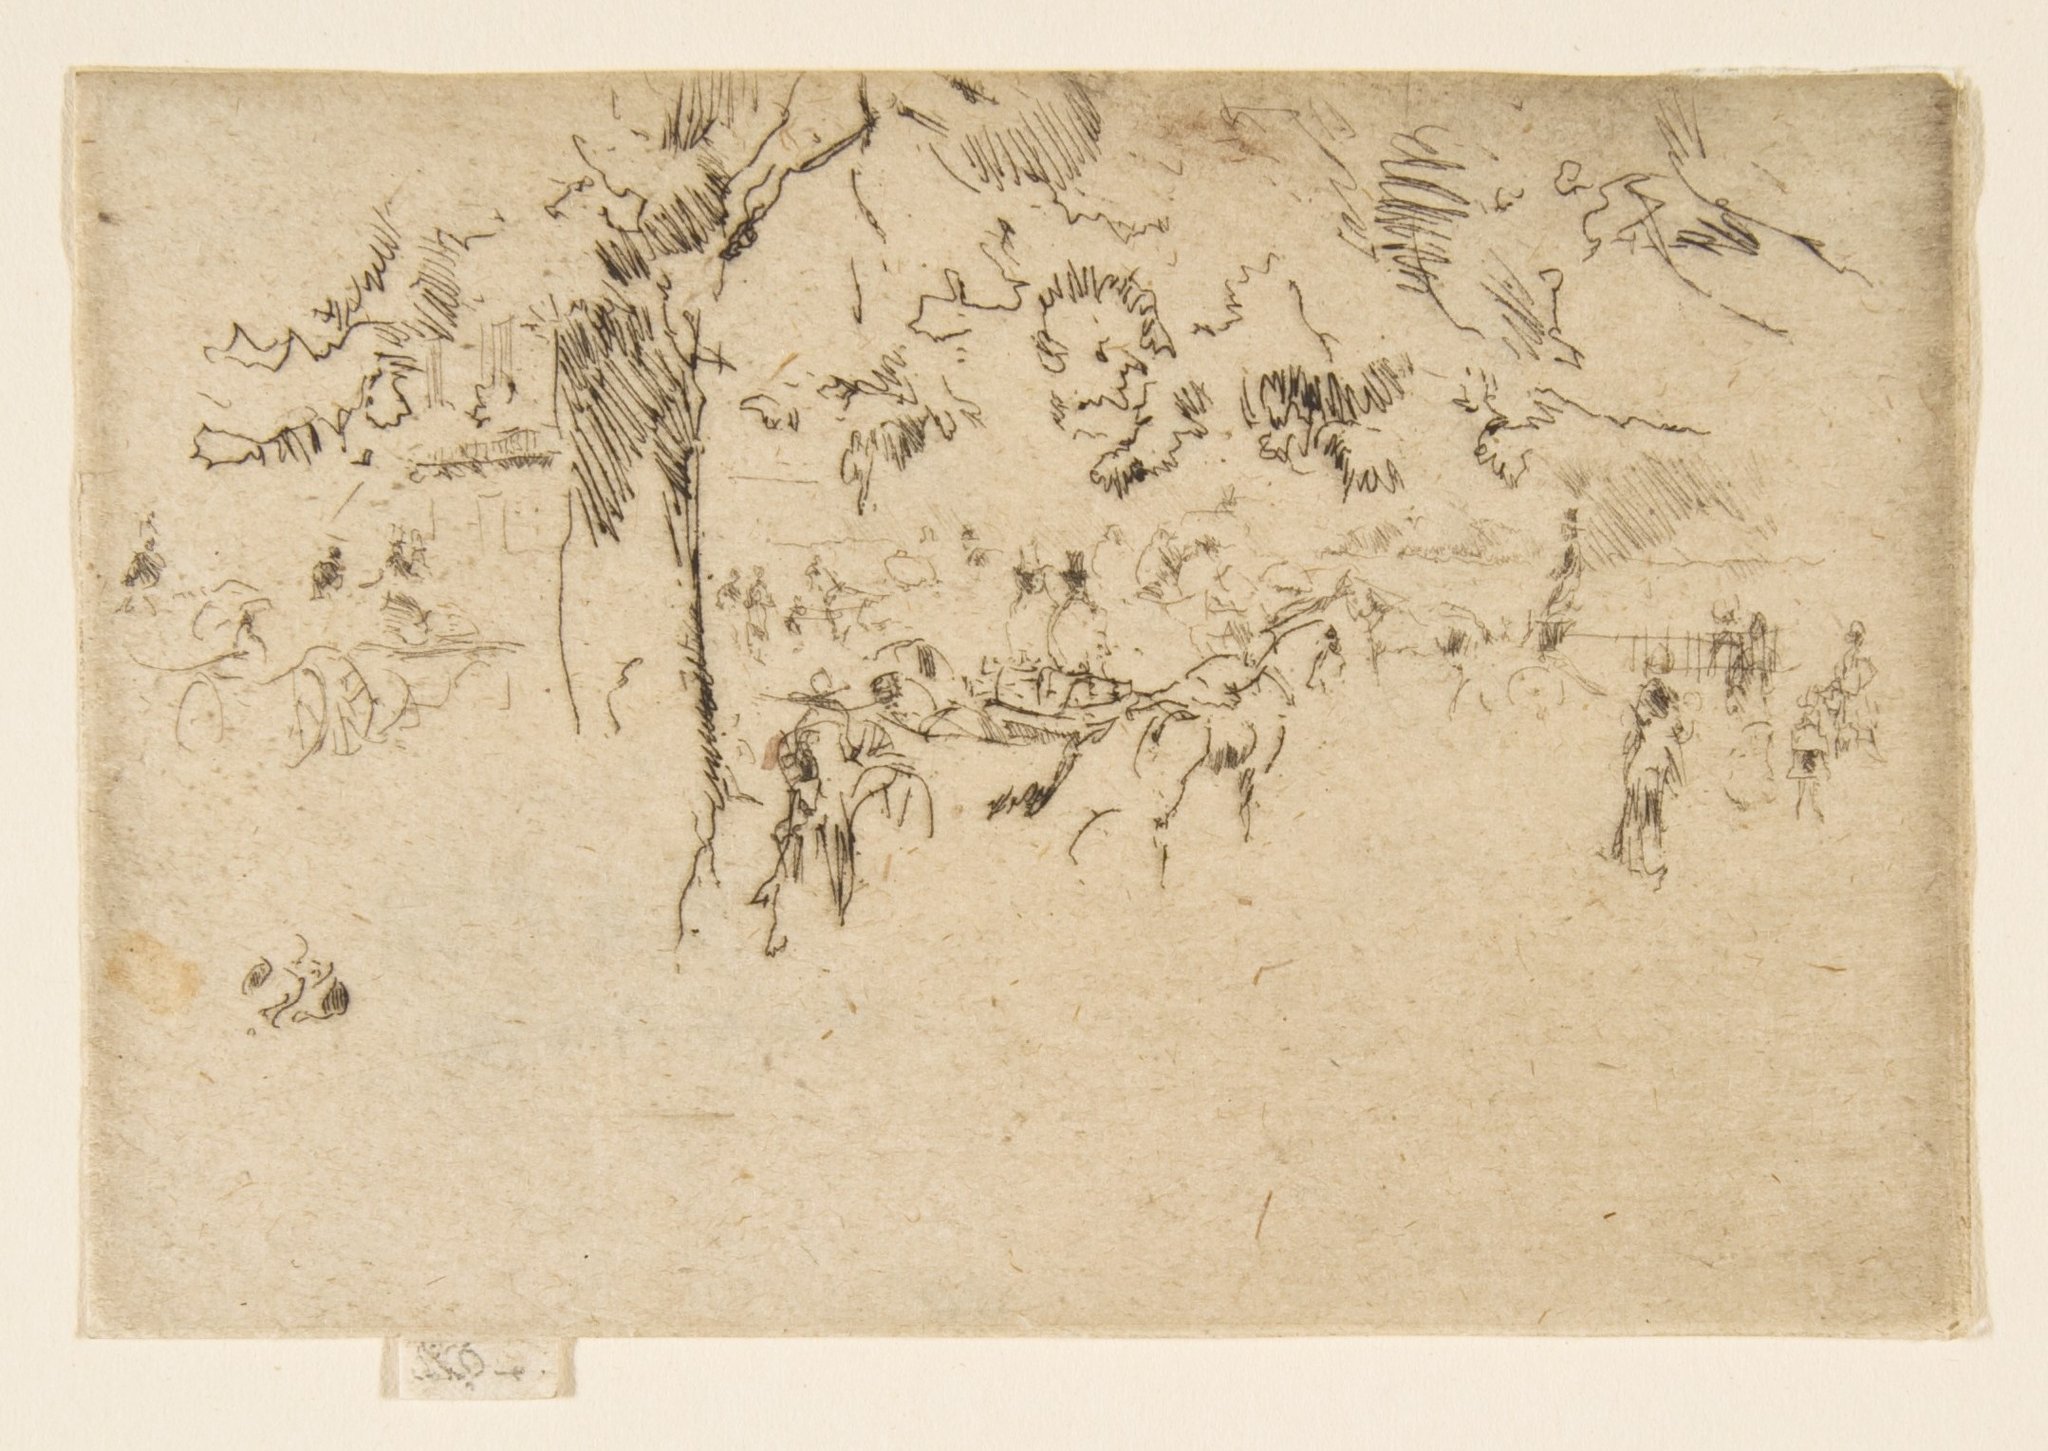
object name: print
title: Sketch in St. James's Park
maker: james mcneill whistler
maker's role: artist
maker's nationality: american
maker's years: 1834-1903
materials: ink, paper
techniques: etching, printing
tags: human figures,parks,trees